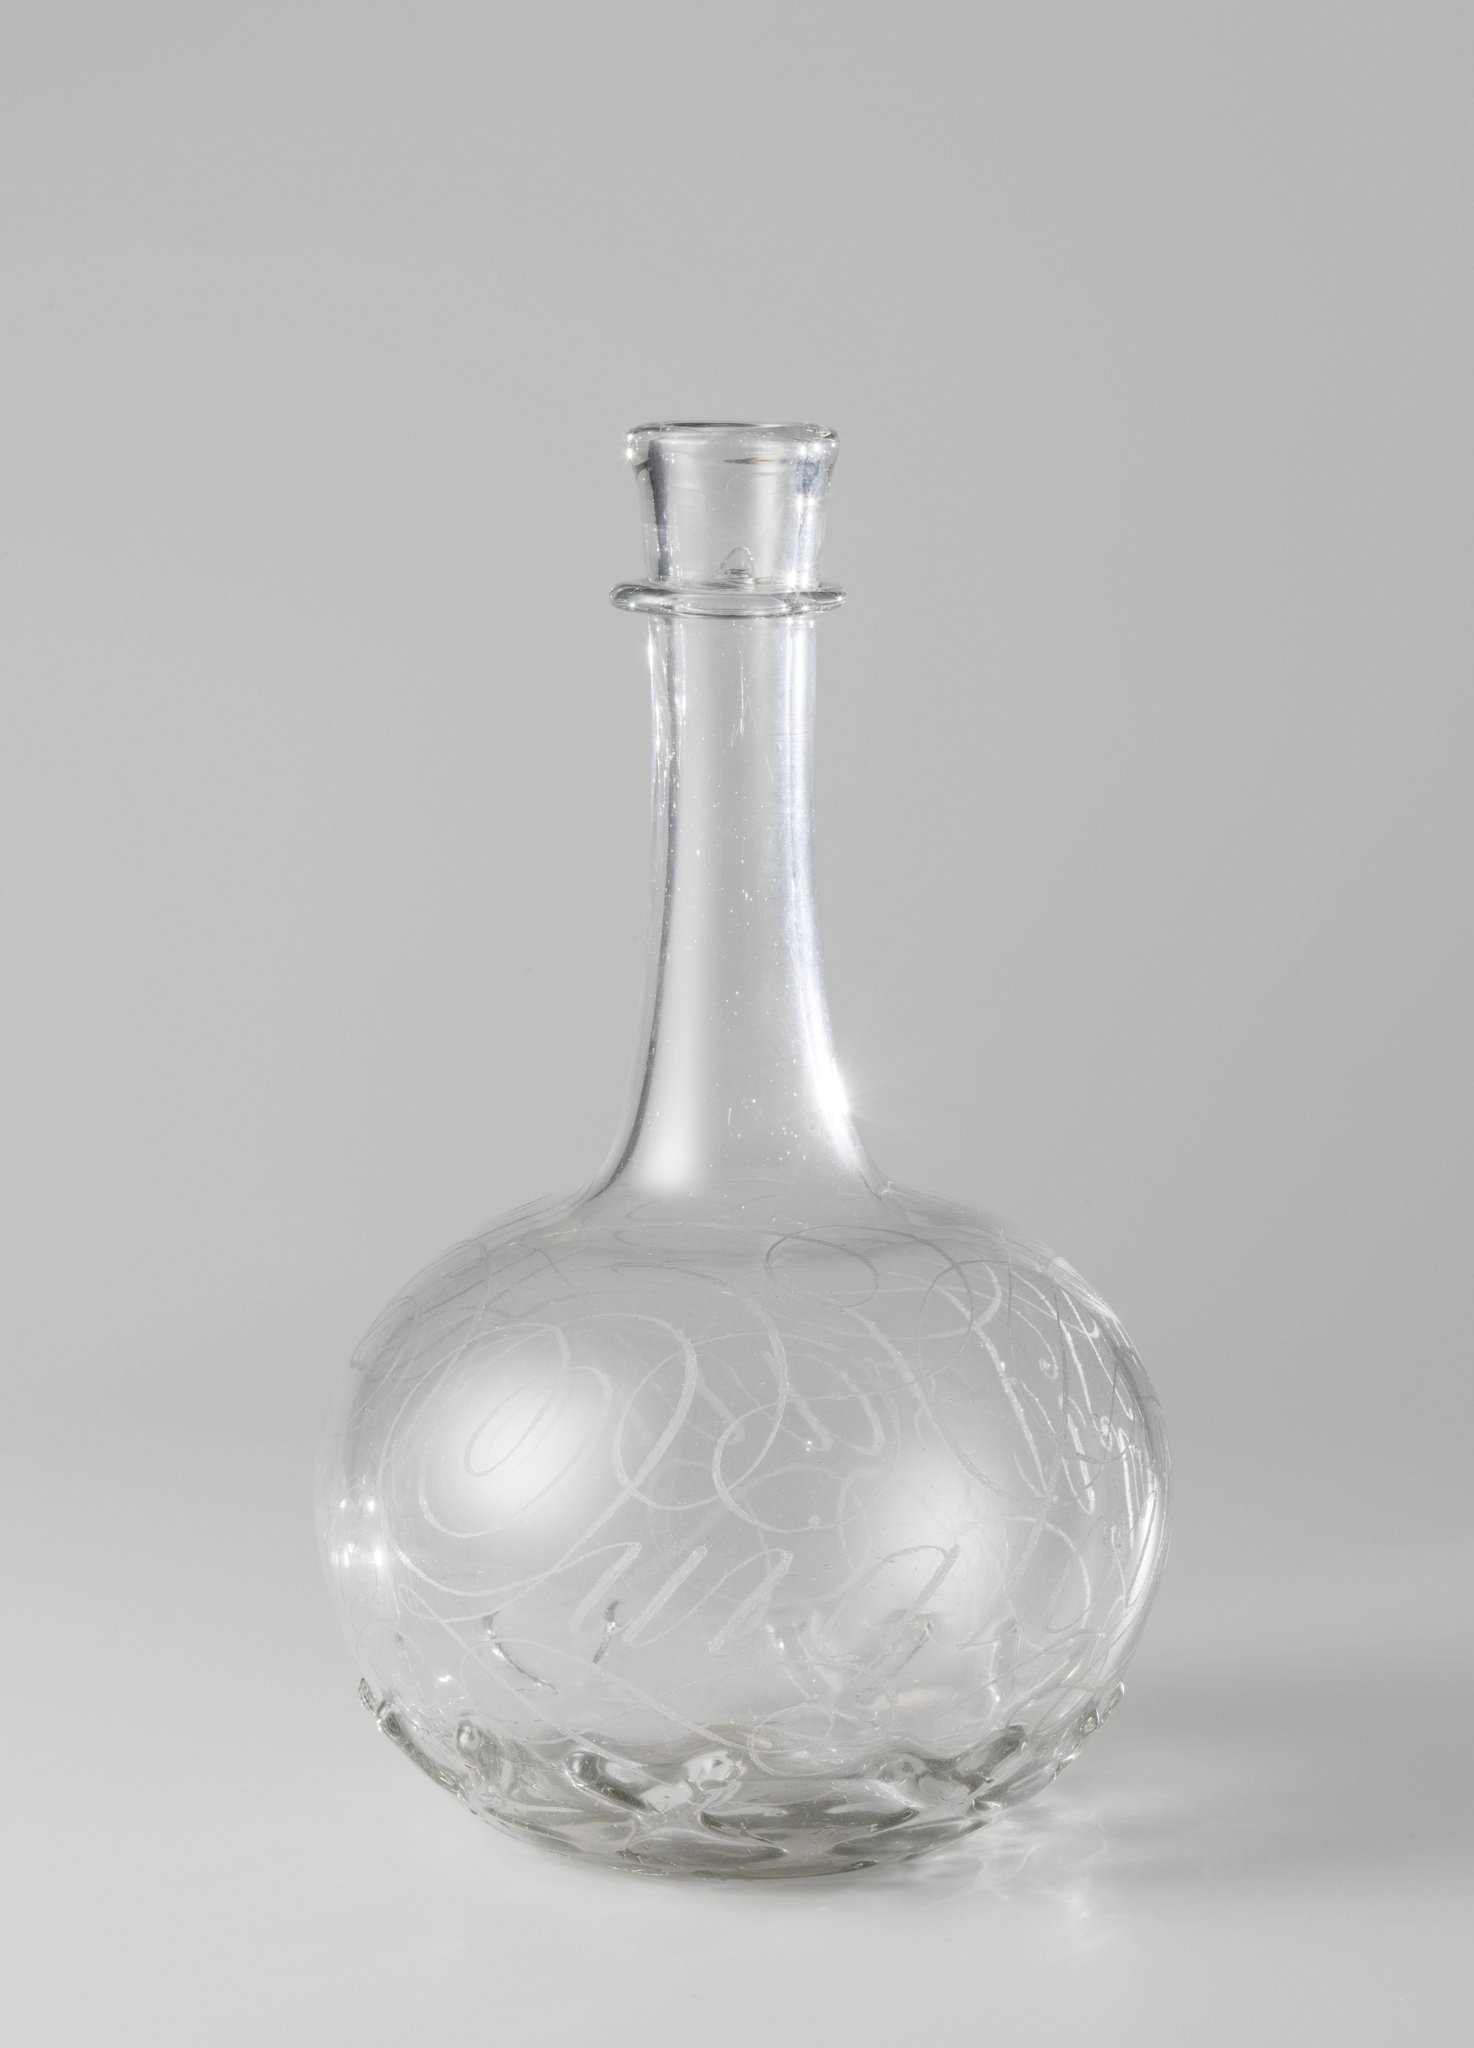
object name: sierfles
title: Fles met het opschrift: Qui a loisir, il fait panier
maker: willem jacobszoon van heemskerk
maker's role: dichter, glasgraveur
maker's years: 1613-1692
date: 1675-1692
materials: glass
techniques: diamond point engraving, glassblowing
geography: leiden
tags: leiden, willem jacobszoon van heemskerk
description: Ingestoken ziel. Bolvormig lichaam, lange slanke hals met opgelegde ring rond de nek. Aan de onderzijde een tweede laag glas in vorm geblazen met ribben die tot een netwerkpatroon zijn geknepen. Op het lichaam gekalligrafeerd opschrift: 'Qui a loisir, il fait panier'.